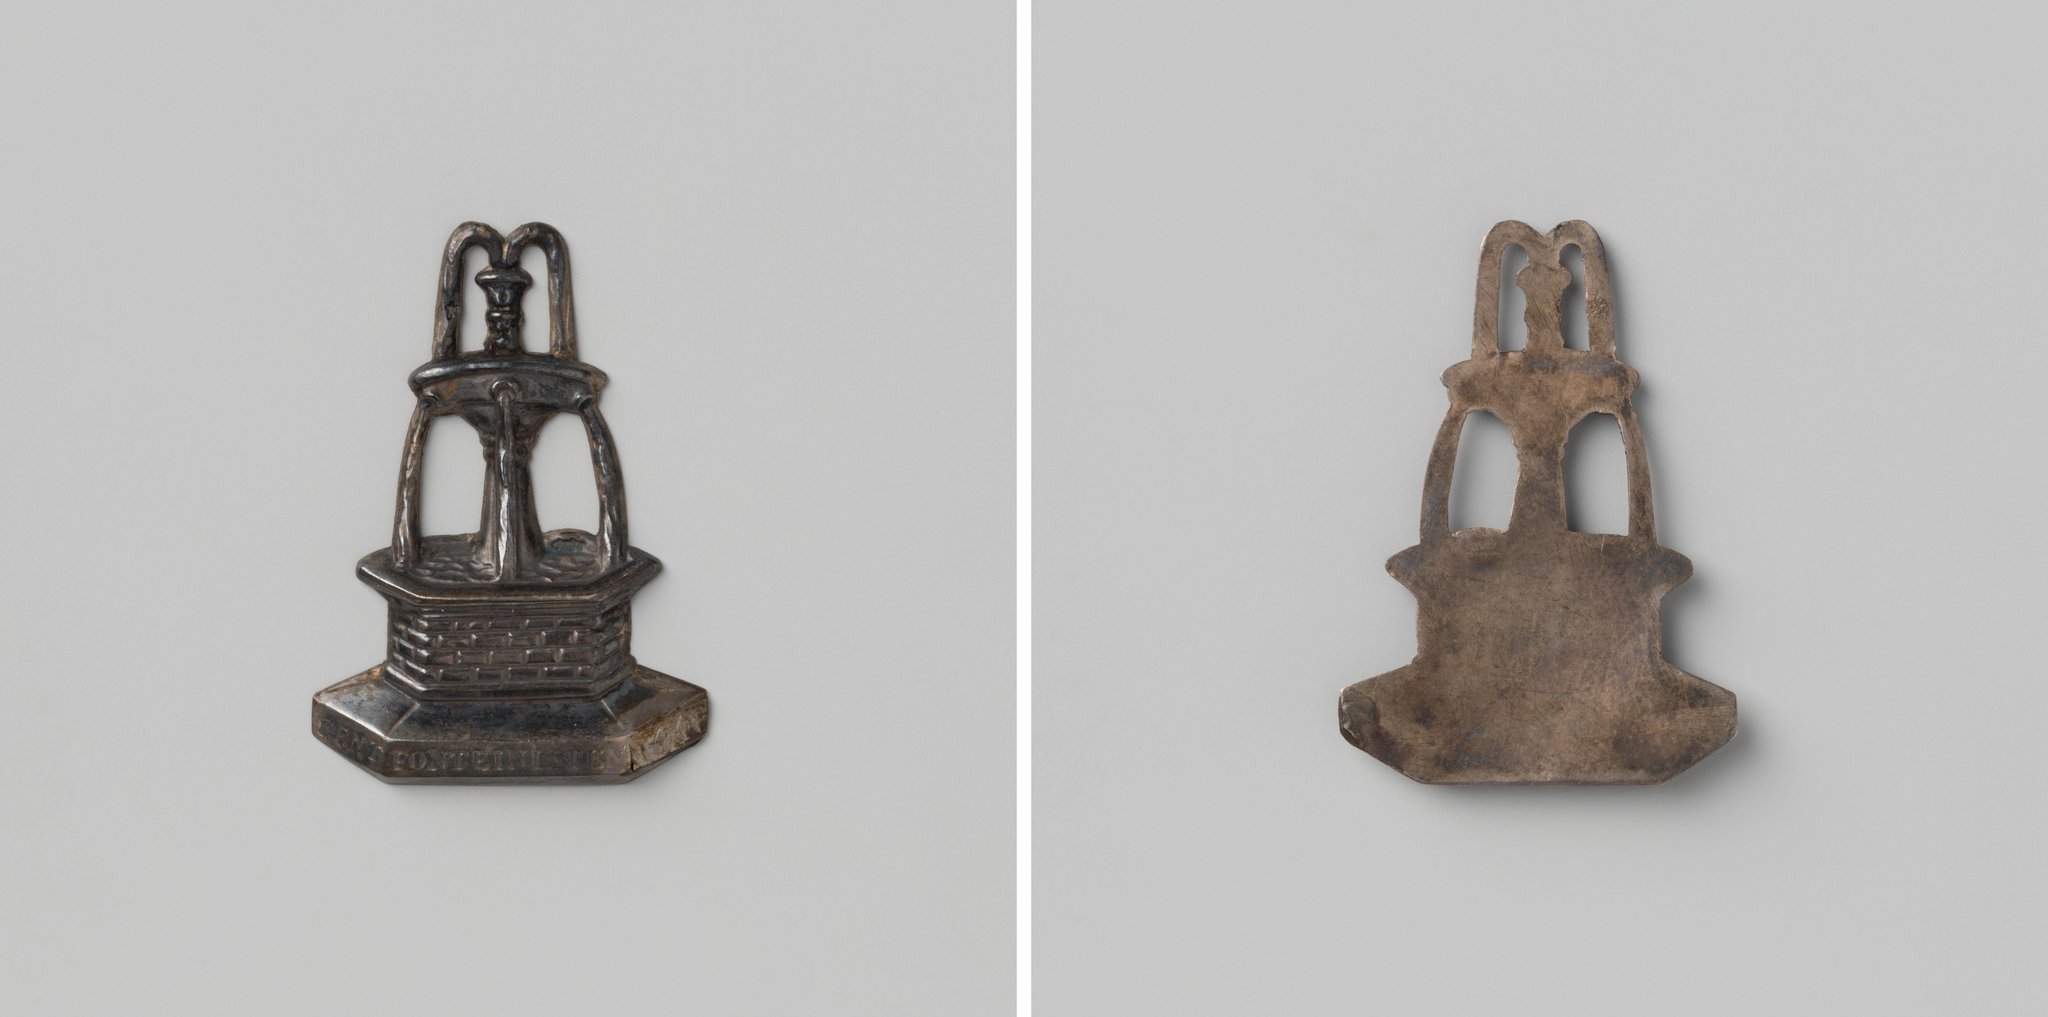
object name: insignia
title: Rederijkerskamer 'de Fonteinisten' te Gent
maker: Anonymous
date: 1825-1875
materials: silver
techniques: striking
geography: ghent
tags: ghent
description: eenzijdig, opengewerkt insigne, voorstellende waterspuitende fontein; op onderste rand: opschrift